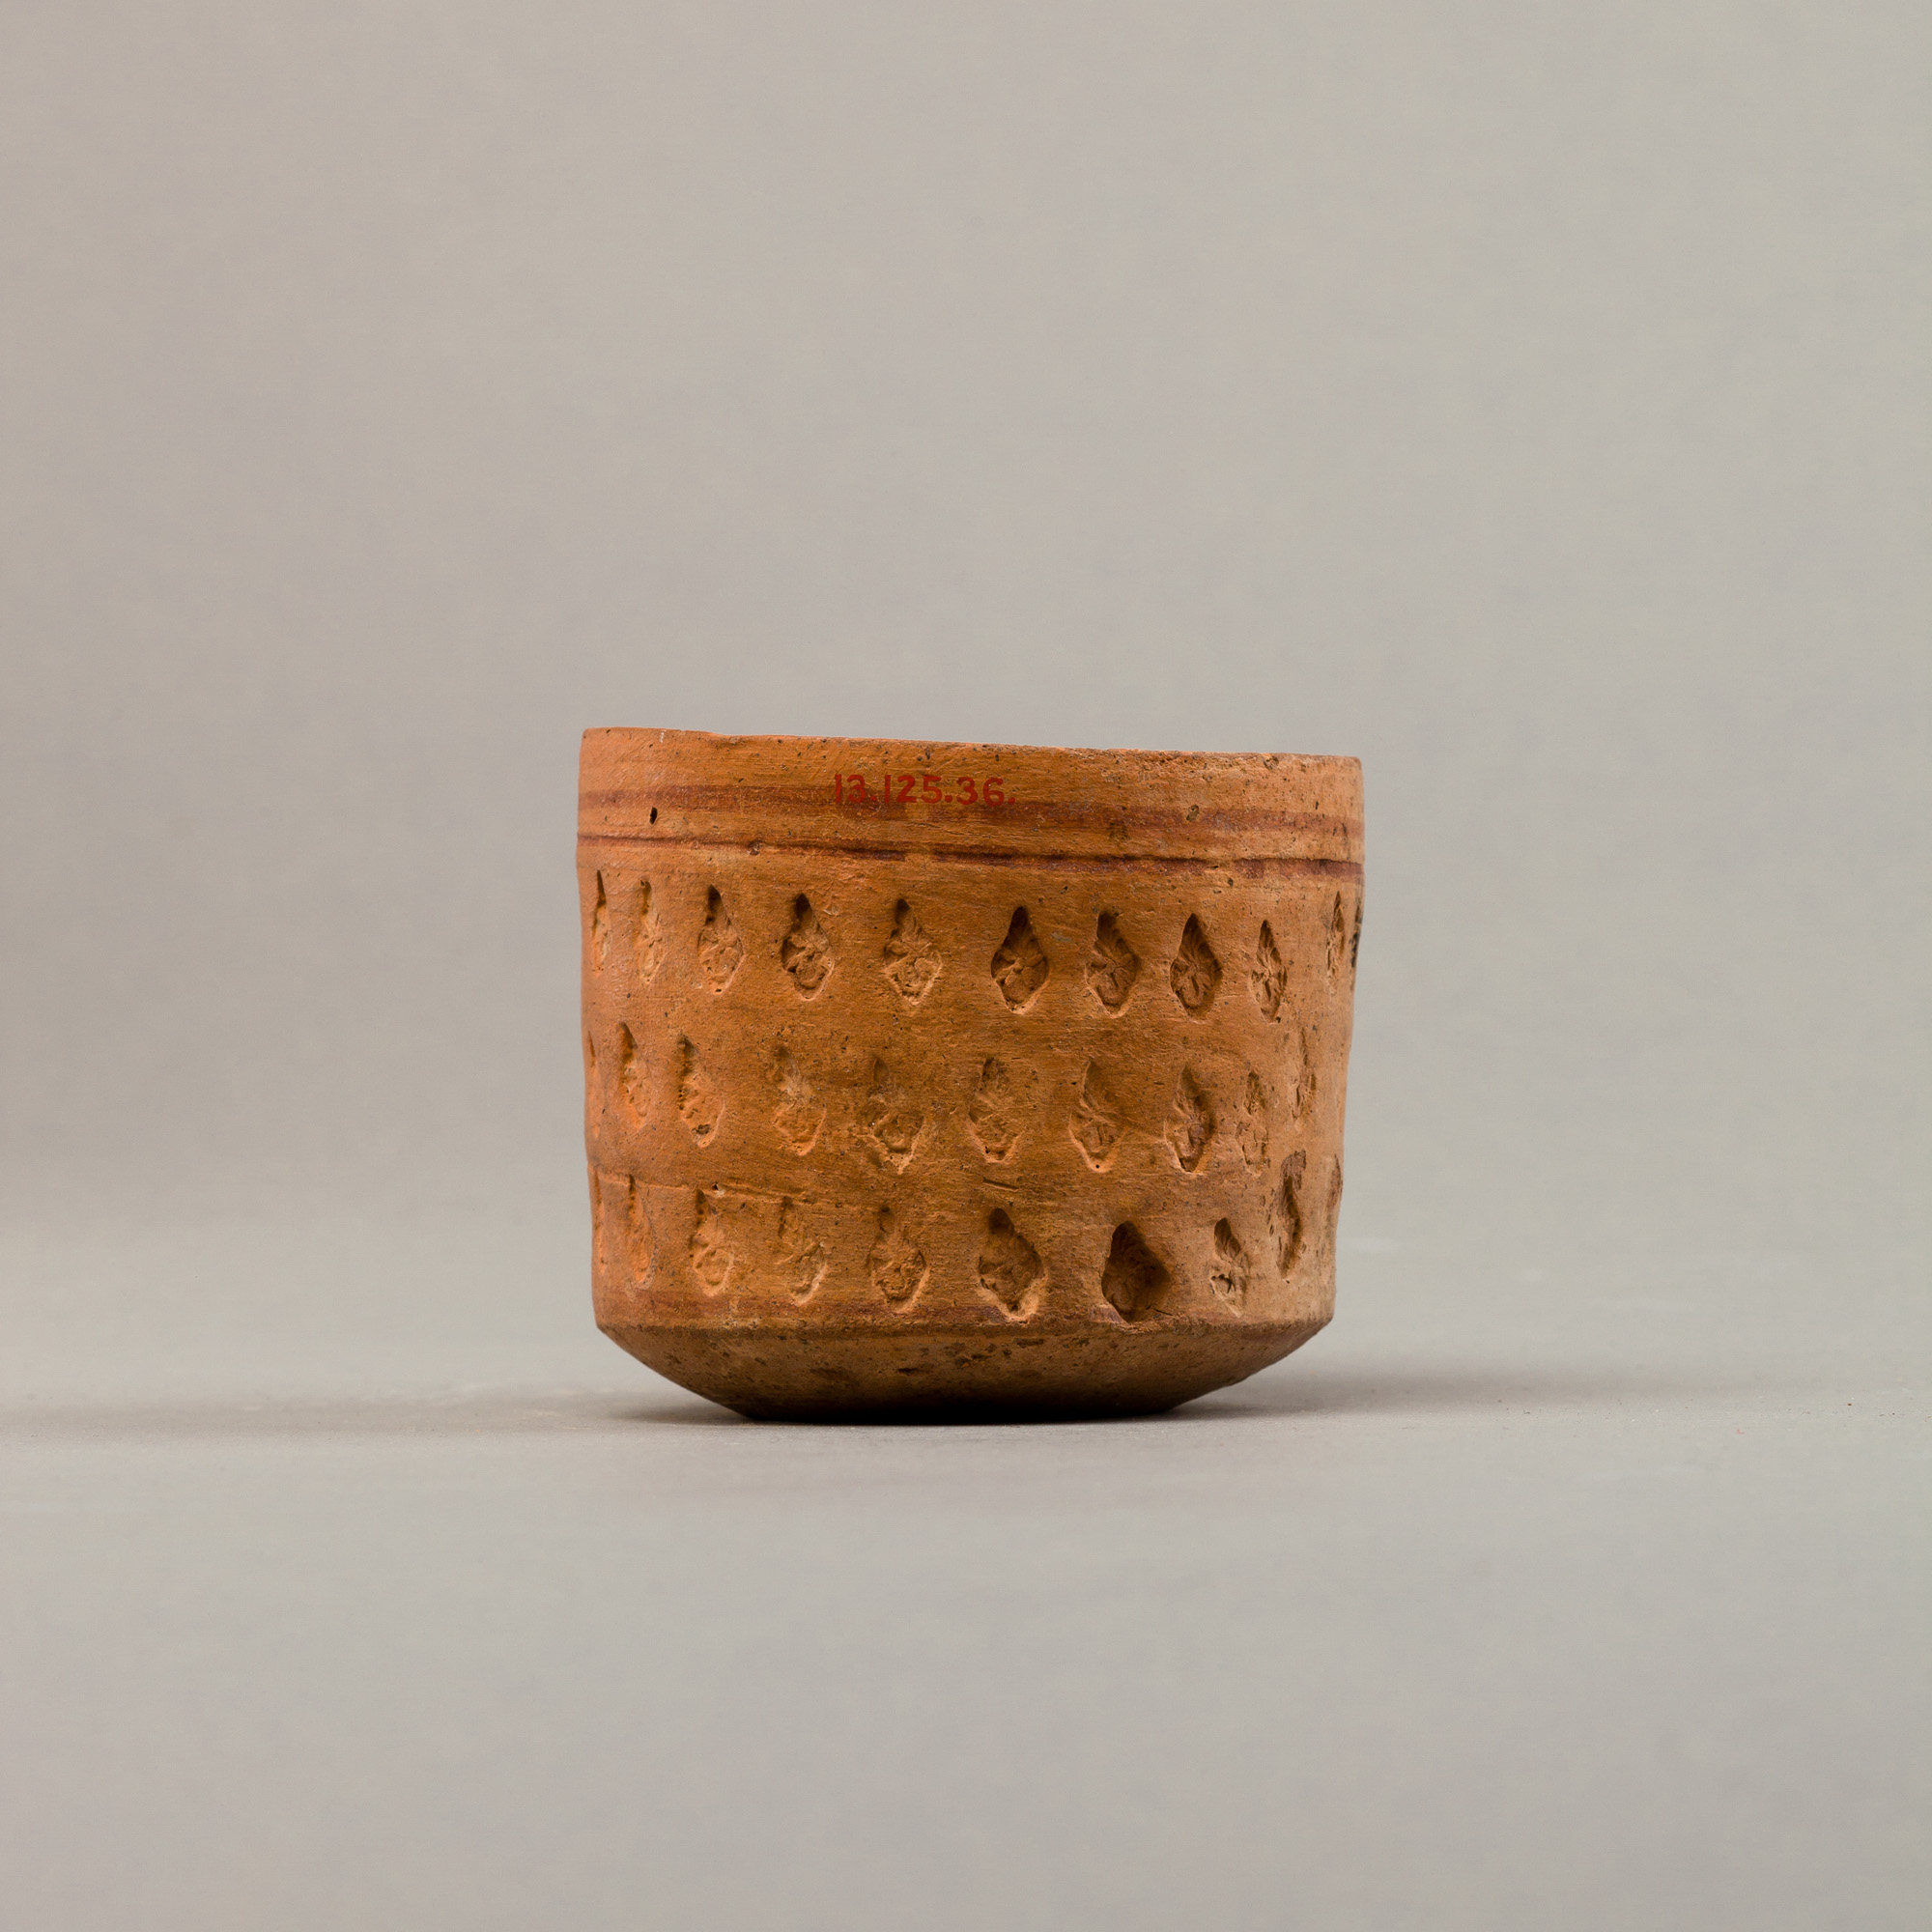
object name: cup, impressed row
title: Cup with three rows of impressed decoration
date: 1-300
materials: paint, pottery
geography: nubia